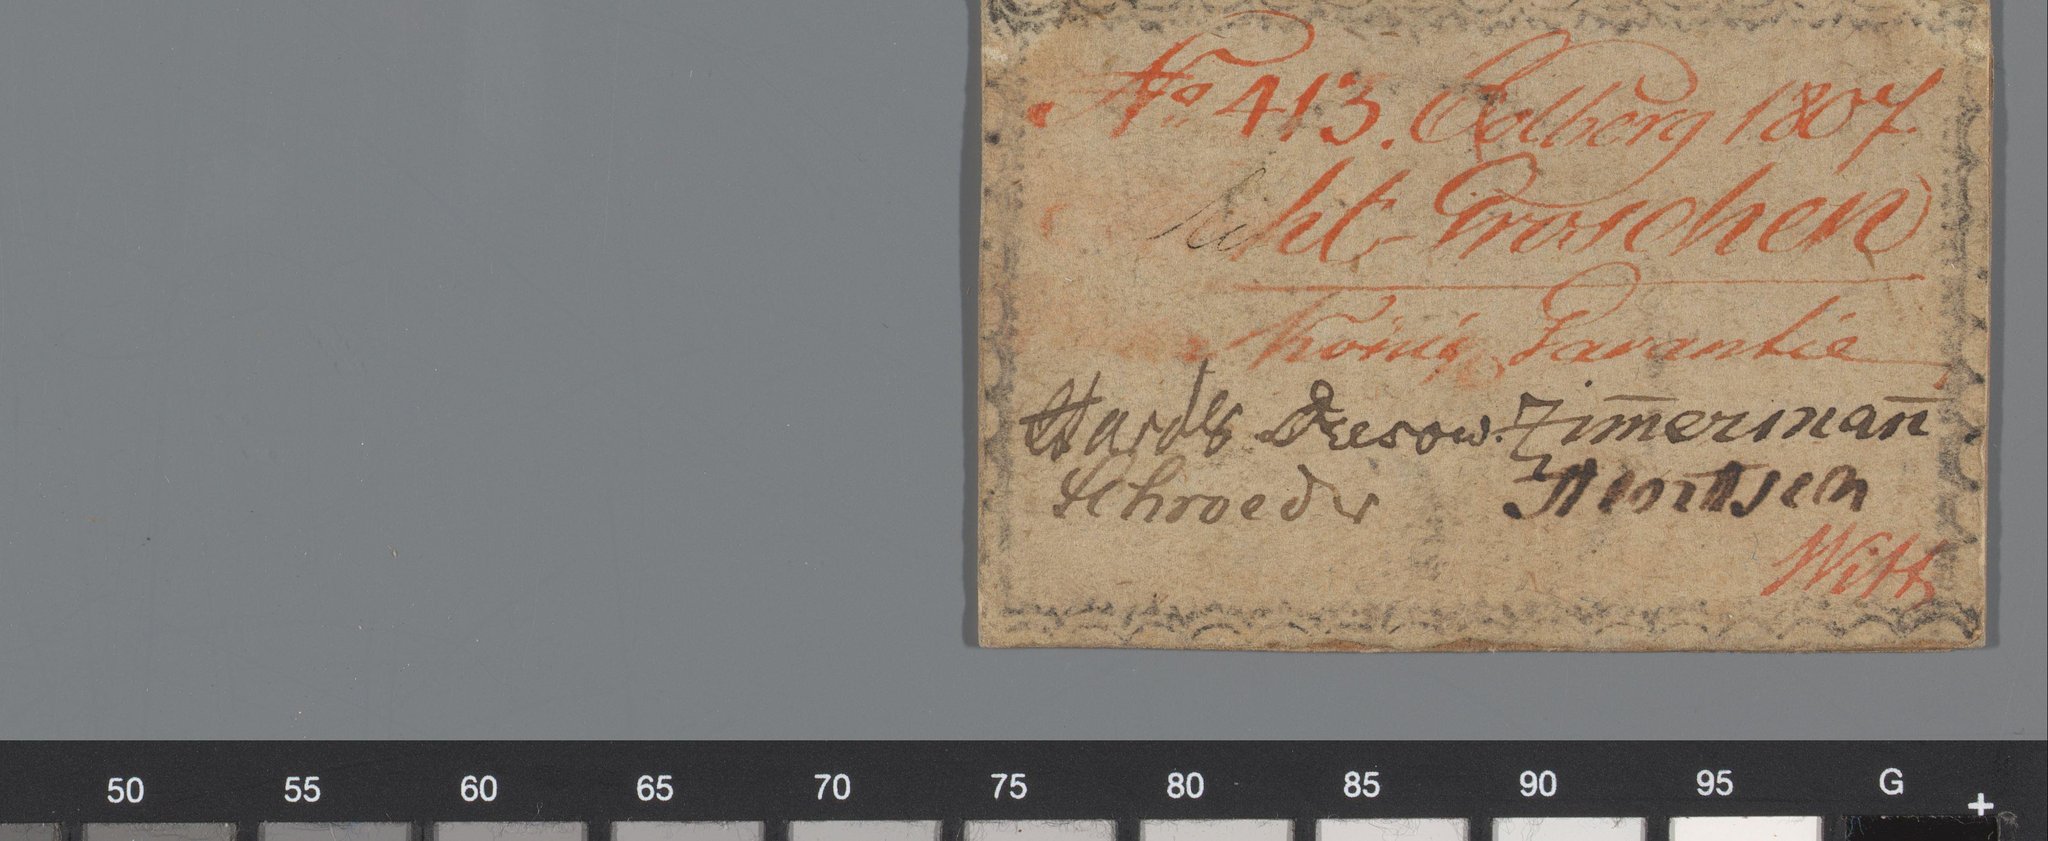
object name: acht groschen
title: Acht groschen: beleg van Konigsberg door de Fransen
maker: Anonymous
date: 1807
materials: paper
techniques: printing, writing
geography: kaliningrad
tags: kaliningrad (stad), beleg van konigsgrad